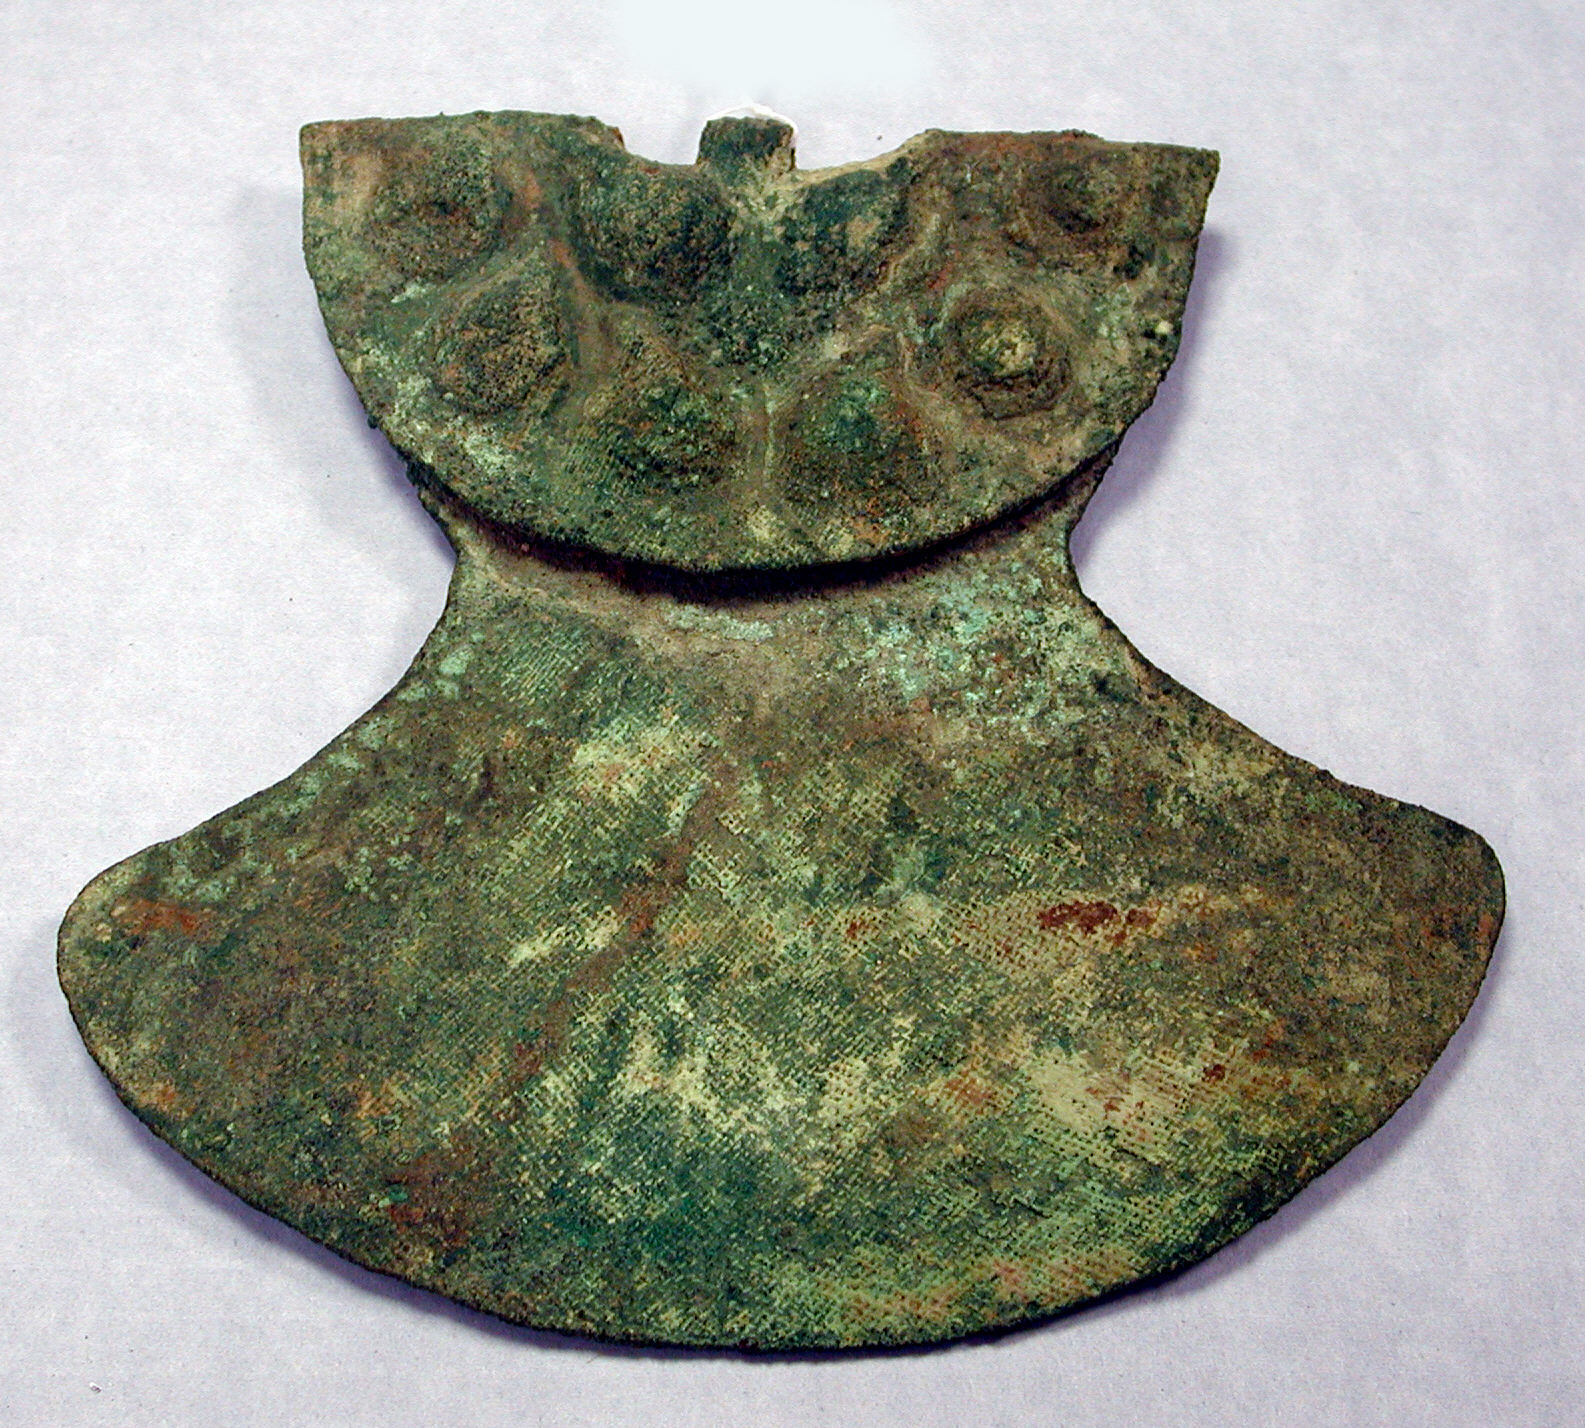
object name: armor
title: Copper Armour Back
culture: moche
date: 101-800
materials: copper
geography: peru